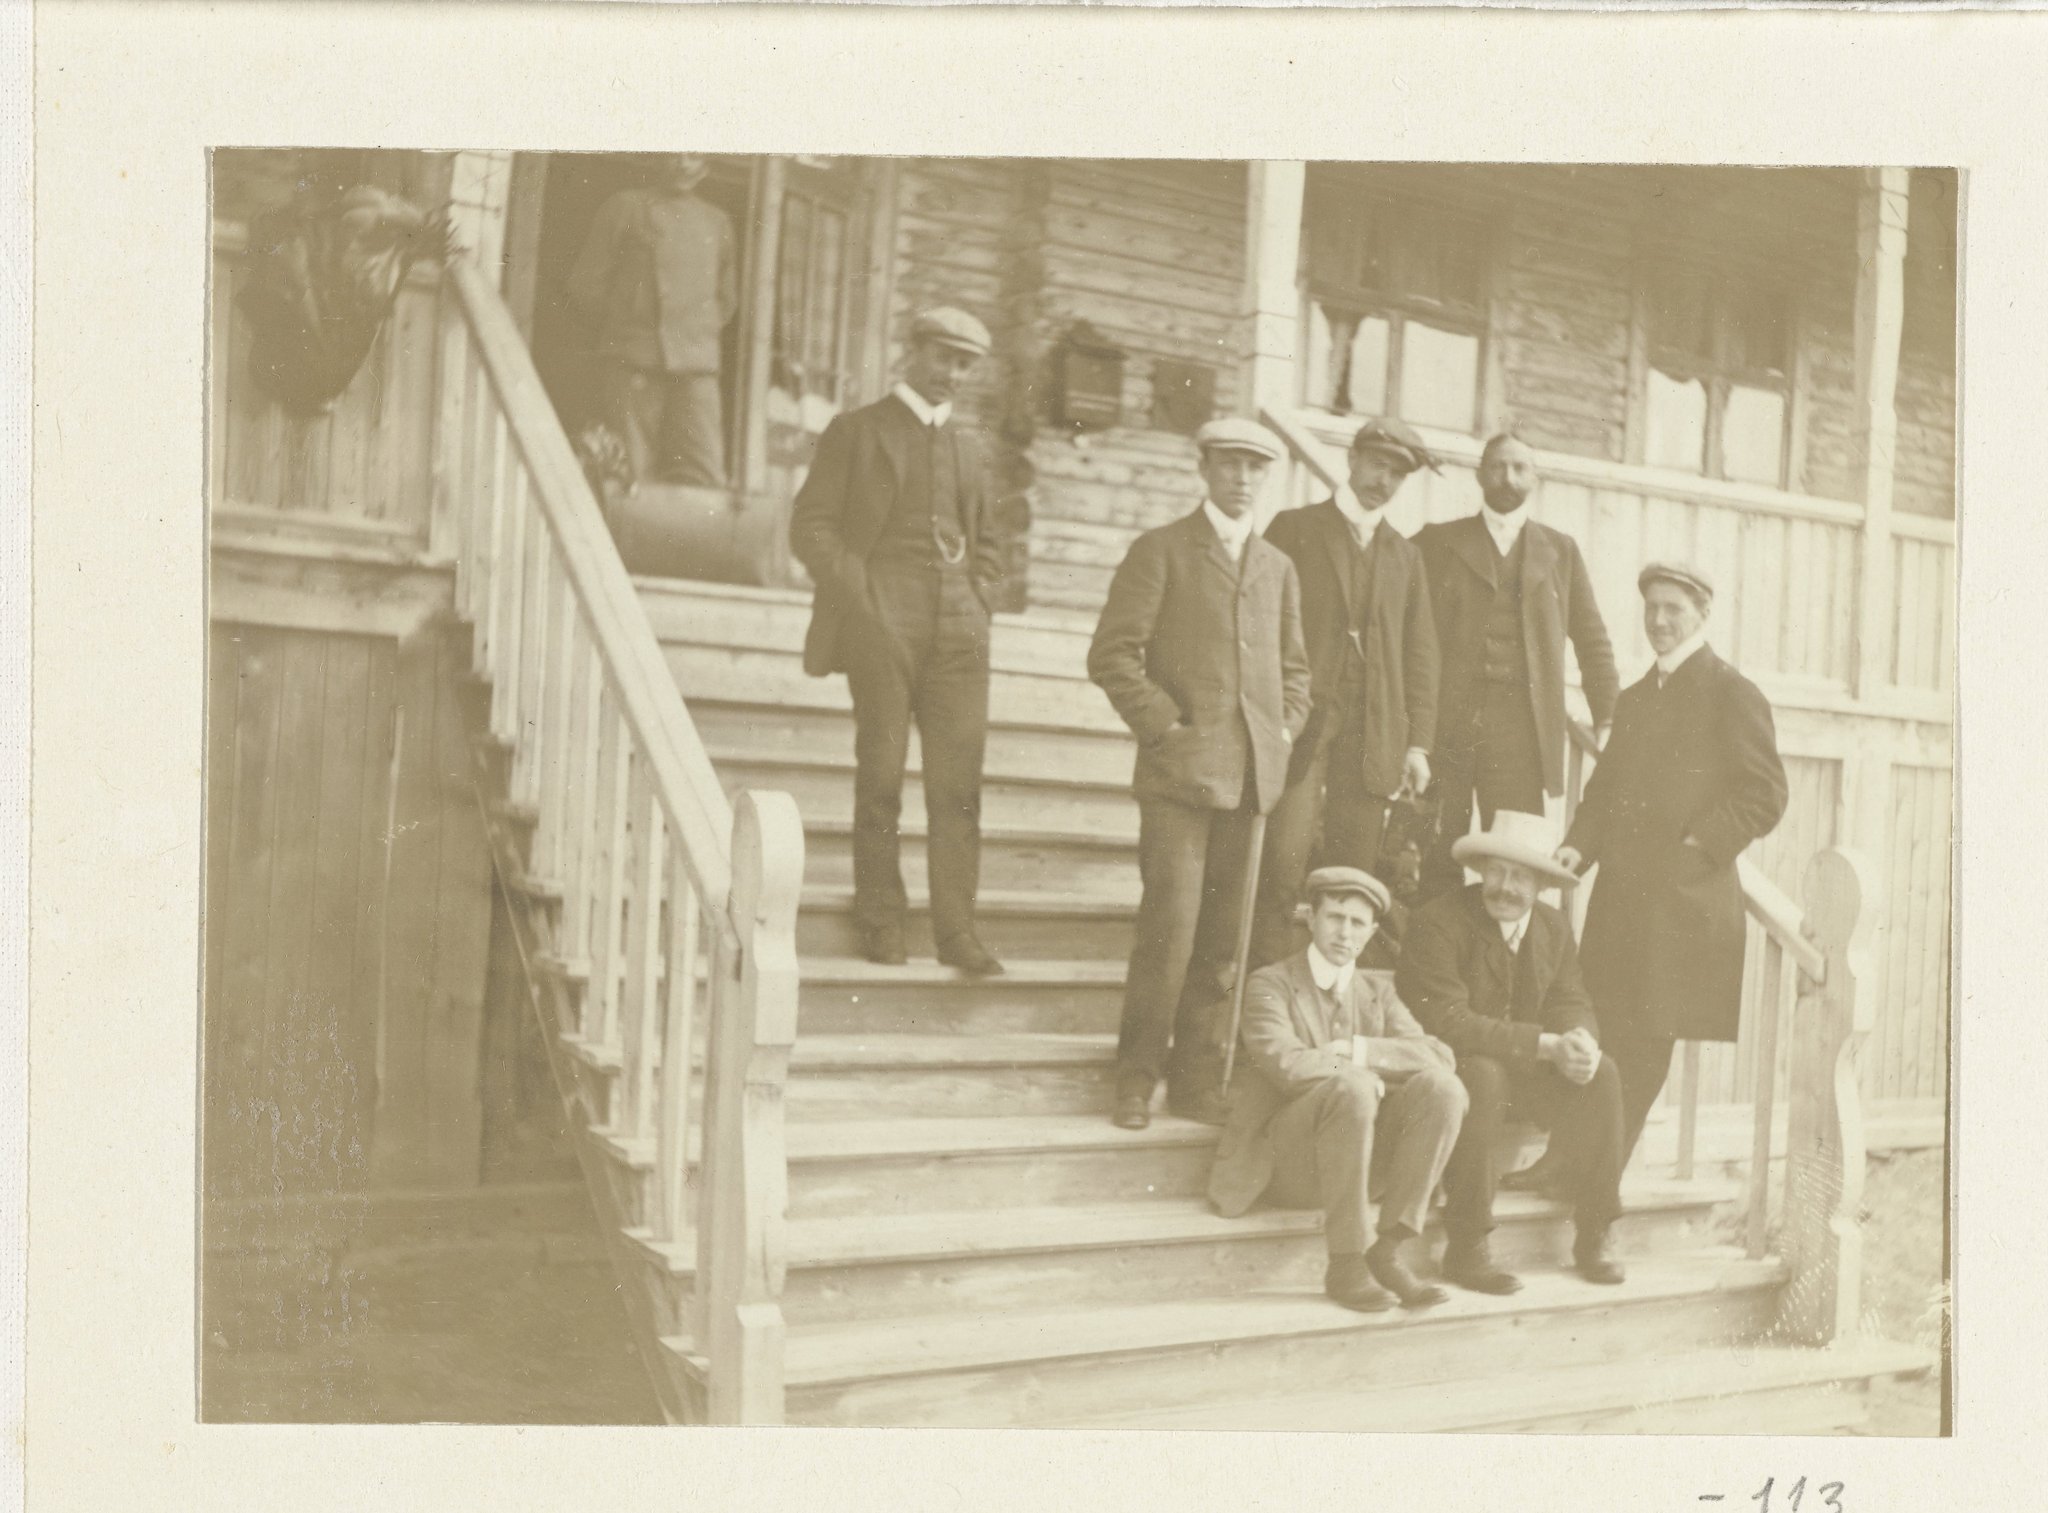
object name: photograph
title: Portret van een gezelschap reisgenoten van Dolph Kessler op de trap voor een houten huis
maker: geldolph adriaan kessler (dolph)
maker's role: fotograaf, industrieel, voetballer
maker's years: 1884-1945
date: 1903-1908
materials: cardboard, photographic support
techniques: gelatin silver print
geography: germany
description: Portret van een gezelschap reisgenoten van Dolph Kessler op de trap voor een houten huis, in Duitsland, Roemenië of Noorwegen. Onderdeel van het fotoalbum van Dolph Kessler met opnamen die hij maakte tijdens zijn verblijf in Engeland en op een wereldreis die hij als secretaris van Henri Deterding (directeur Koninklijke Olie) ondernam naar Nederlands-Indië, Japan, China en de Verenigde Staten, tussen 1906 en 1908.